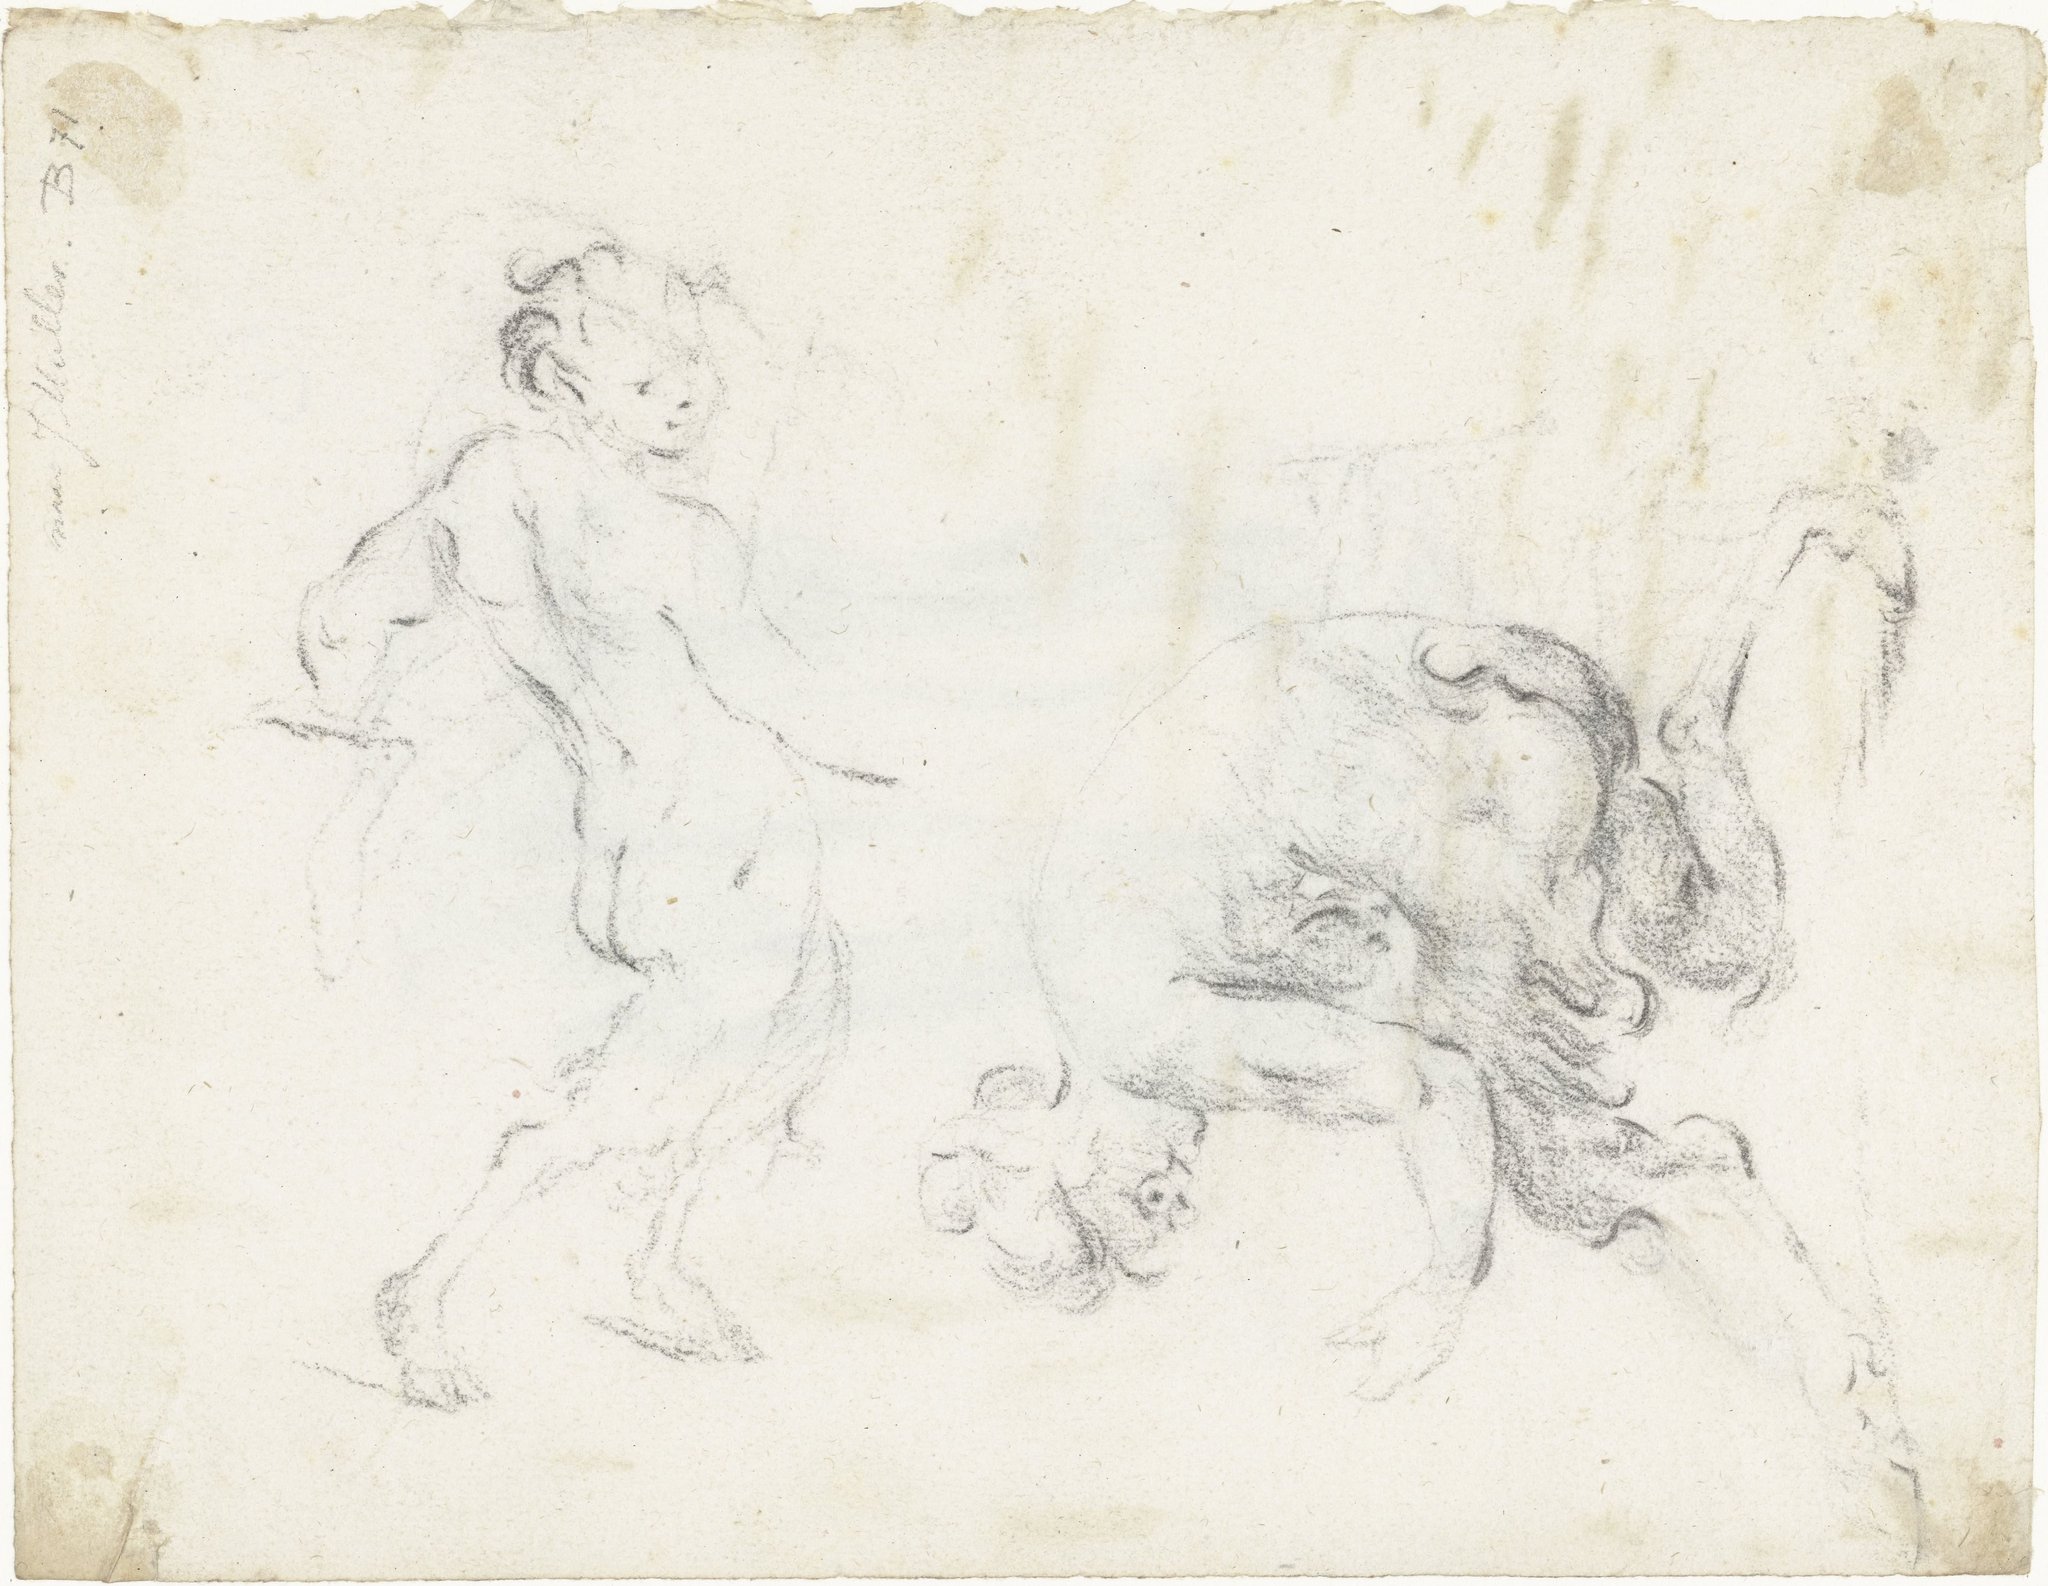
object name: drawing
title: Studieblad met twee saters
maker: moses ter borch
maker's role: draughtsman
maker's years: 1645-1667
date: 1656-1657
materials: chalk, paper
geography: zwolle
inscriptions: inscription: ‘naar J. Muller. B 71’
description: Kopie naar "Saters trekken een doorn uit", gegraveerd door J. Muller naar B. Spranger.